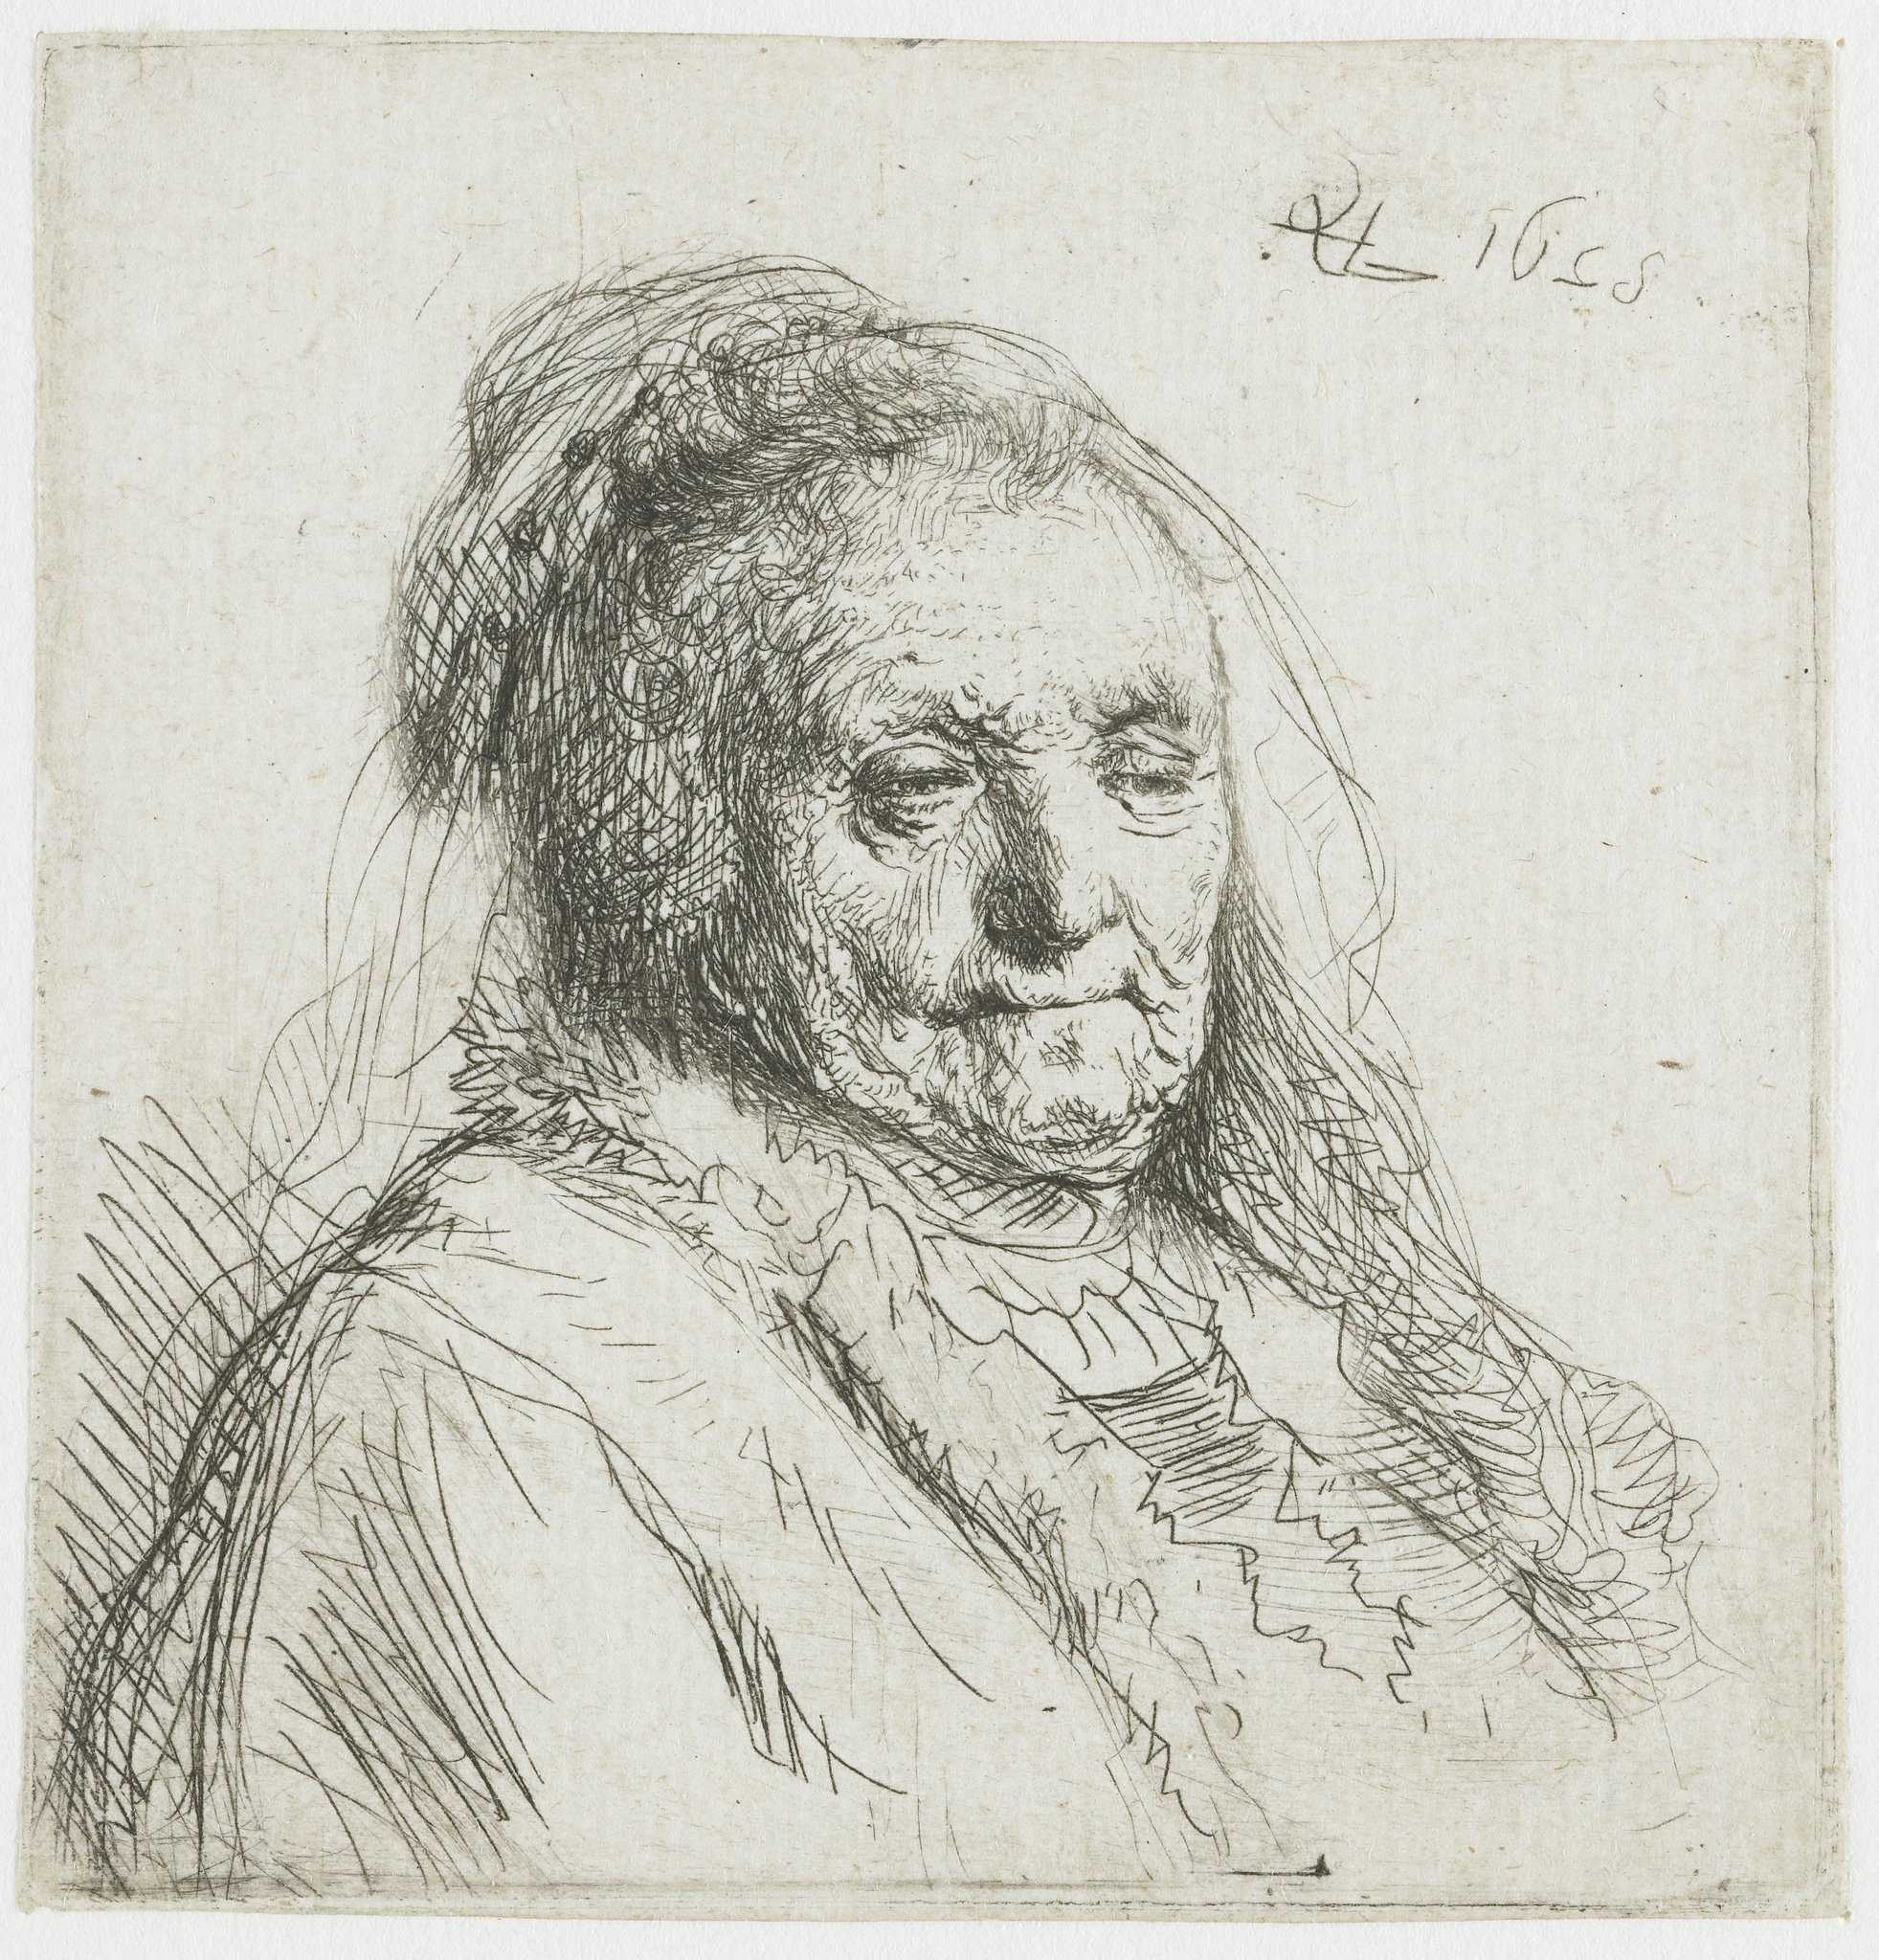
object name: print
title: The artist's mother, head and bust: three quarters right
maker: rembrandt van rijn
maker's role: draughtsman, painter, print maker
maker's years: 1606-1669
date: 1628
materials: paper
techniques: etching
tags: neeltje willemsdr. zuytbrouck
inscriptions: mark: Lugt 2228, monogram and date: ‘RHL 1628’